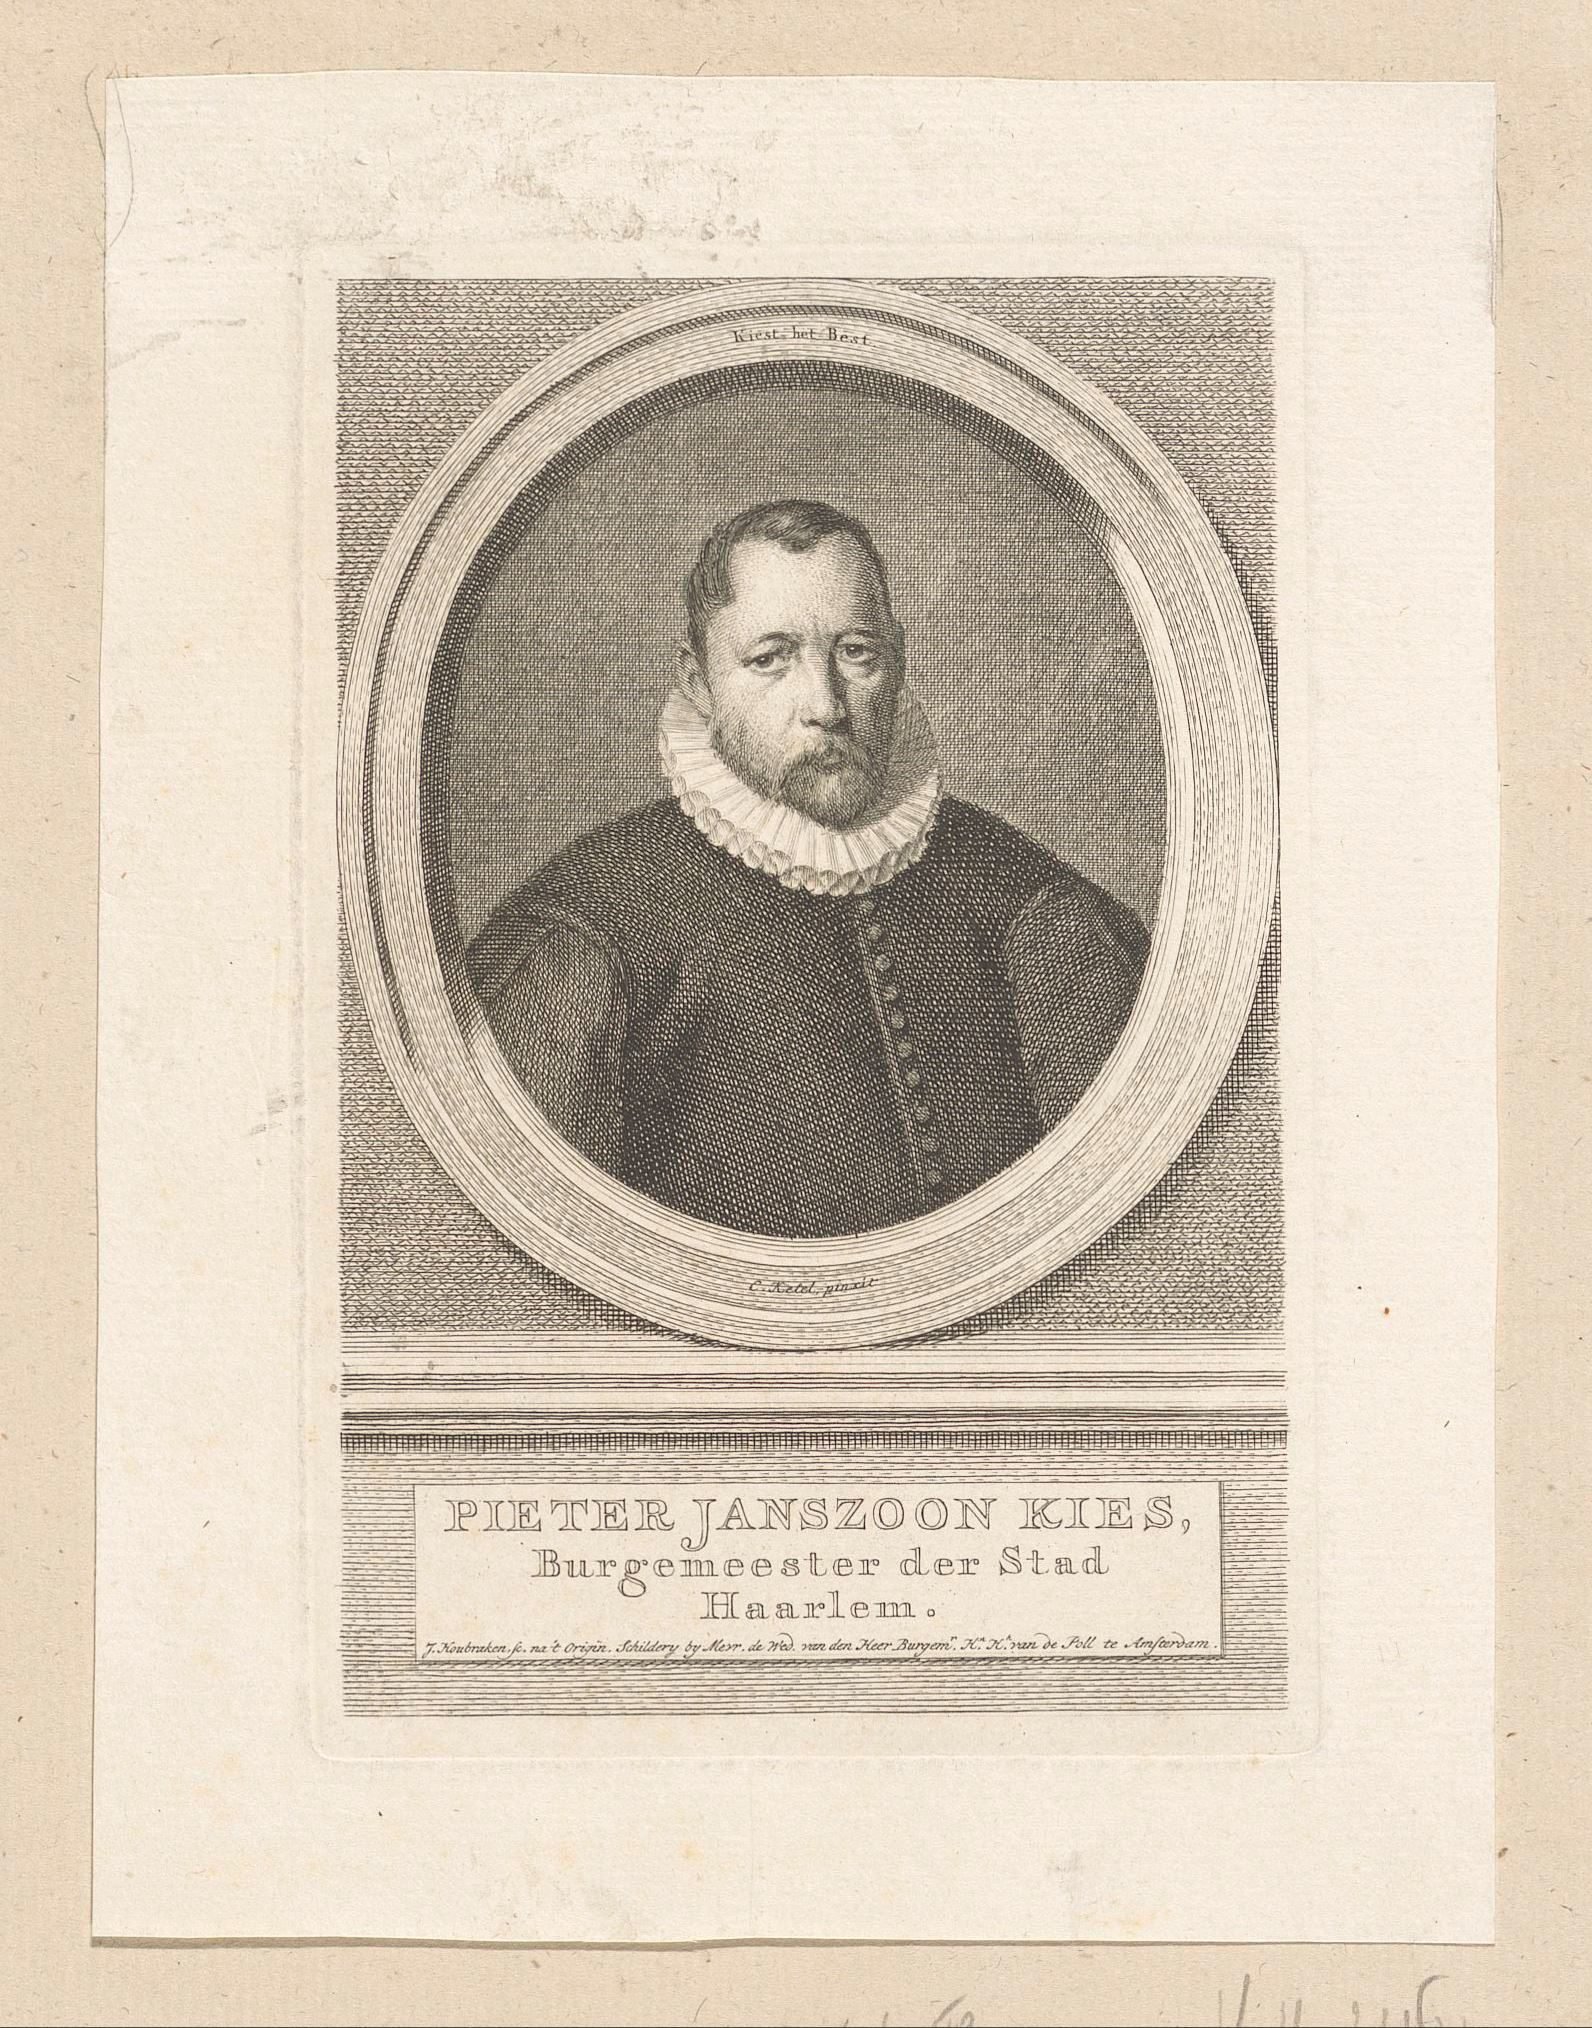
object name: print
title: Portret van Pieter Janszoon Kies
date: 1749-1780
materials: paper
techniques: engraving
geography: amsterdam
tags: historical persons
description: Deze prent is oorspronkelijk bedoeld als aanvulling op Jan Wagenaars ‘Vaderlandsche historie’* en was zo vanaf 1796 verkrijgbaar bij Johannes Allart te Amsterdam. Voor de advertentie waarin Allart de 60 portretten en 7 platen, allen gegraveerd door Houbraken, ter aanvulling op Wagenaars ‘Vaderlandsche historie’ aanbiedt, zie RP-P-OB-77.766. *Van dit werk zijn in de achttiende eeuw meerdere uitgaves verschenen, zoals: Wagenaar, Jan. Vaderlandsche historie, vervattende de geschiedenissen der Vereenigde Nederlanden (…). 21 delen. Amsterdam: Isaak Tirion, 1749-1759. Wagenaar, Jan. Vaderlandsche historie, vervattende de geschiedenissen der nu Vereenigde Nederlanden (…). 21 delen. Amsterdam: weduwe Isaak Tirion, 1770. Wagenaar, Jan. Vaderlandsche historie, vervattende de geschiedenissen der nu Vereenigde Nederlanden (…). 21 delen. Amsterdam, Leiden, Dordrecht en Harlingen: P. Schouten e.a., 1782. Wagenaar, Jan. Vaderlandsche historie, vervattende de geschiedenissen der nu Vereenigde Nederlanden (…). 21 delen. Amsterdam: Johannes Allart, 1790-1796.